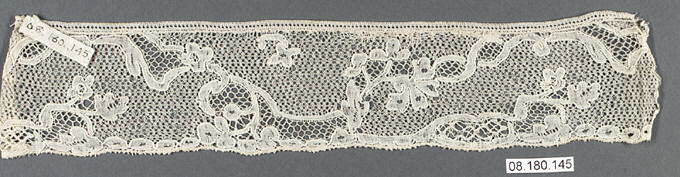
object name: piece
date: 1701-1733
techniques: lace